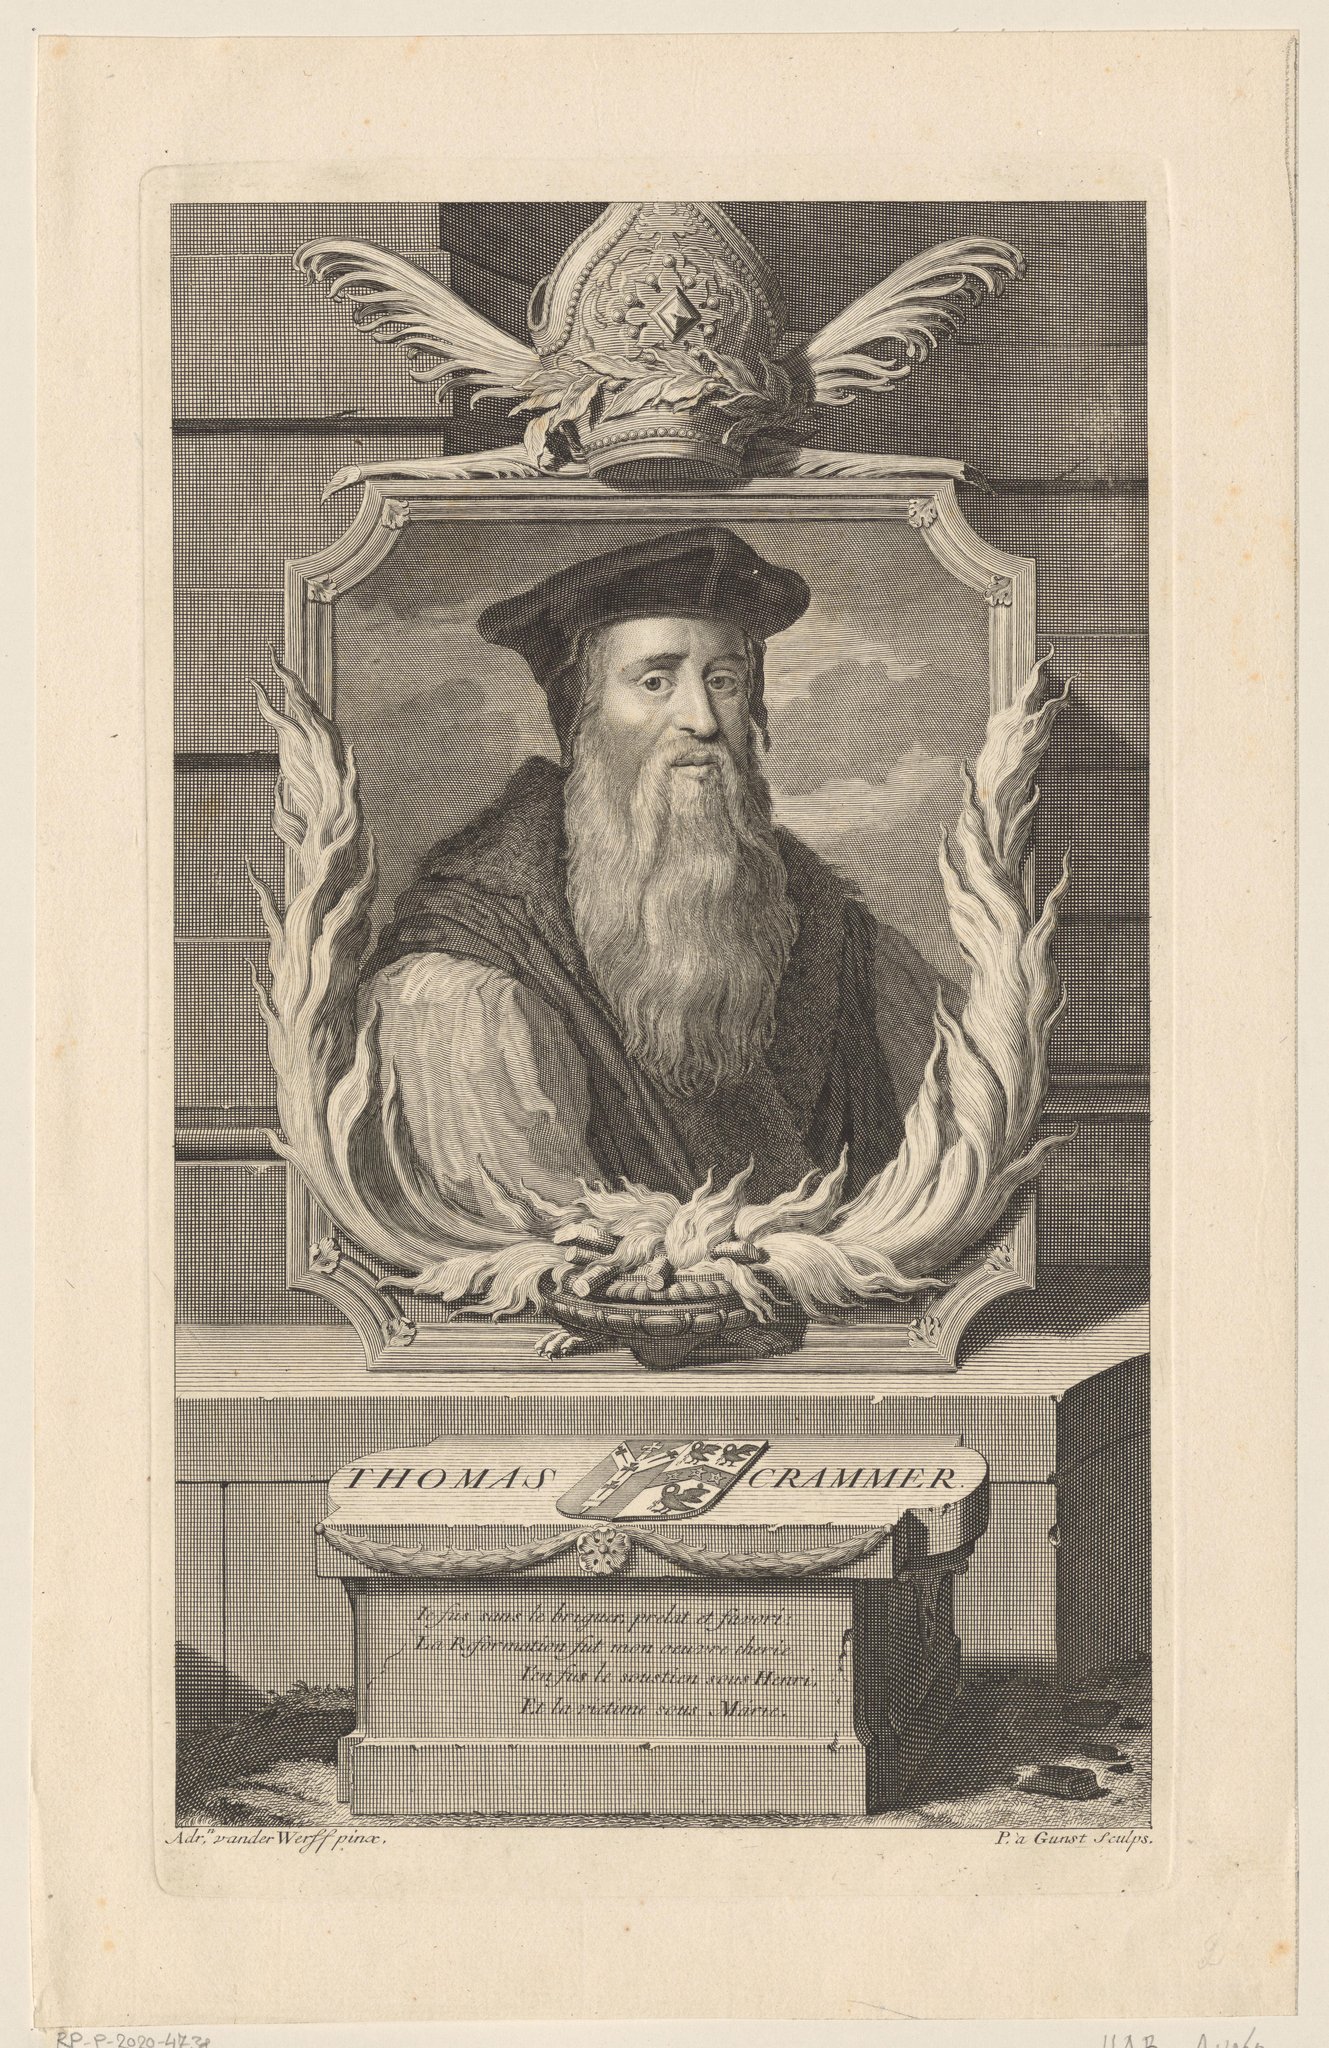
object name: print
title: Portret van Thomas Cranmer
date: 1697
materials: paper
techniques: engraving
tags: theologian, historical persons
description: Prent waarschijnlijk uit: Larrey, Isaac. Histoire d'Angleterre, d'Ecosse (...). Rotterdam: Reinier Leers, 1697, dl. 4.